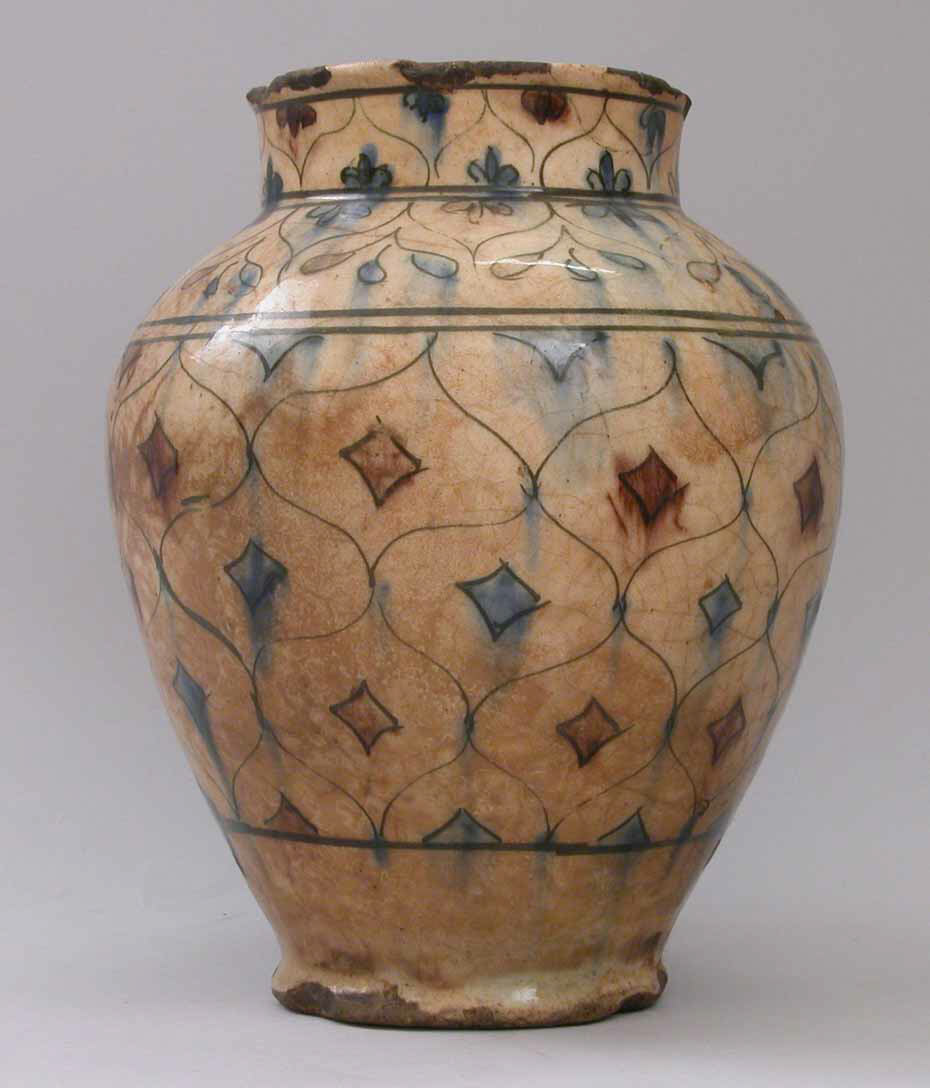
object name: jar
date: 1701-1800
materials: stonepaste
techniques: painting, underglaze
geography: iran